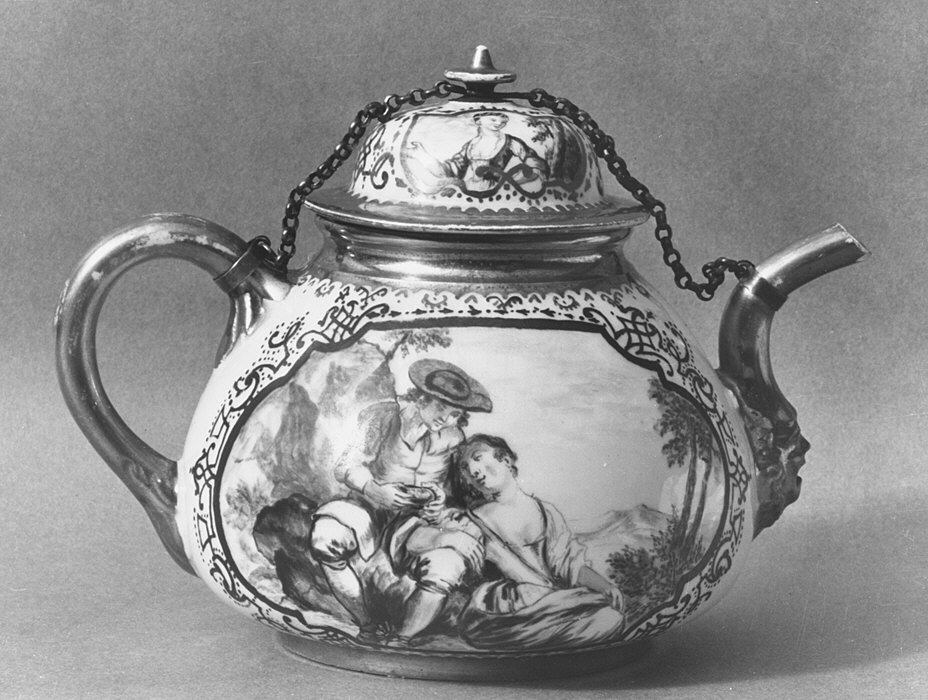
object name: teapot with cover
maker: meissen manufactory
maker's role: manufactory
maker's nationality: german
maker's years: 1710-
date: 1730-1735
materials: hard paste porcelain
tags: musical instruments,men,women